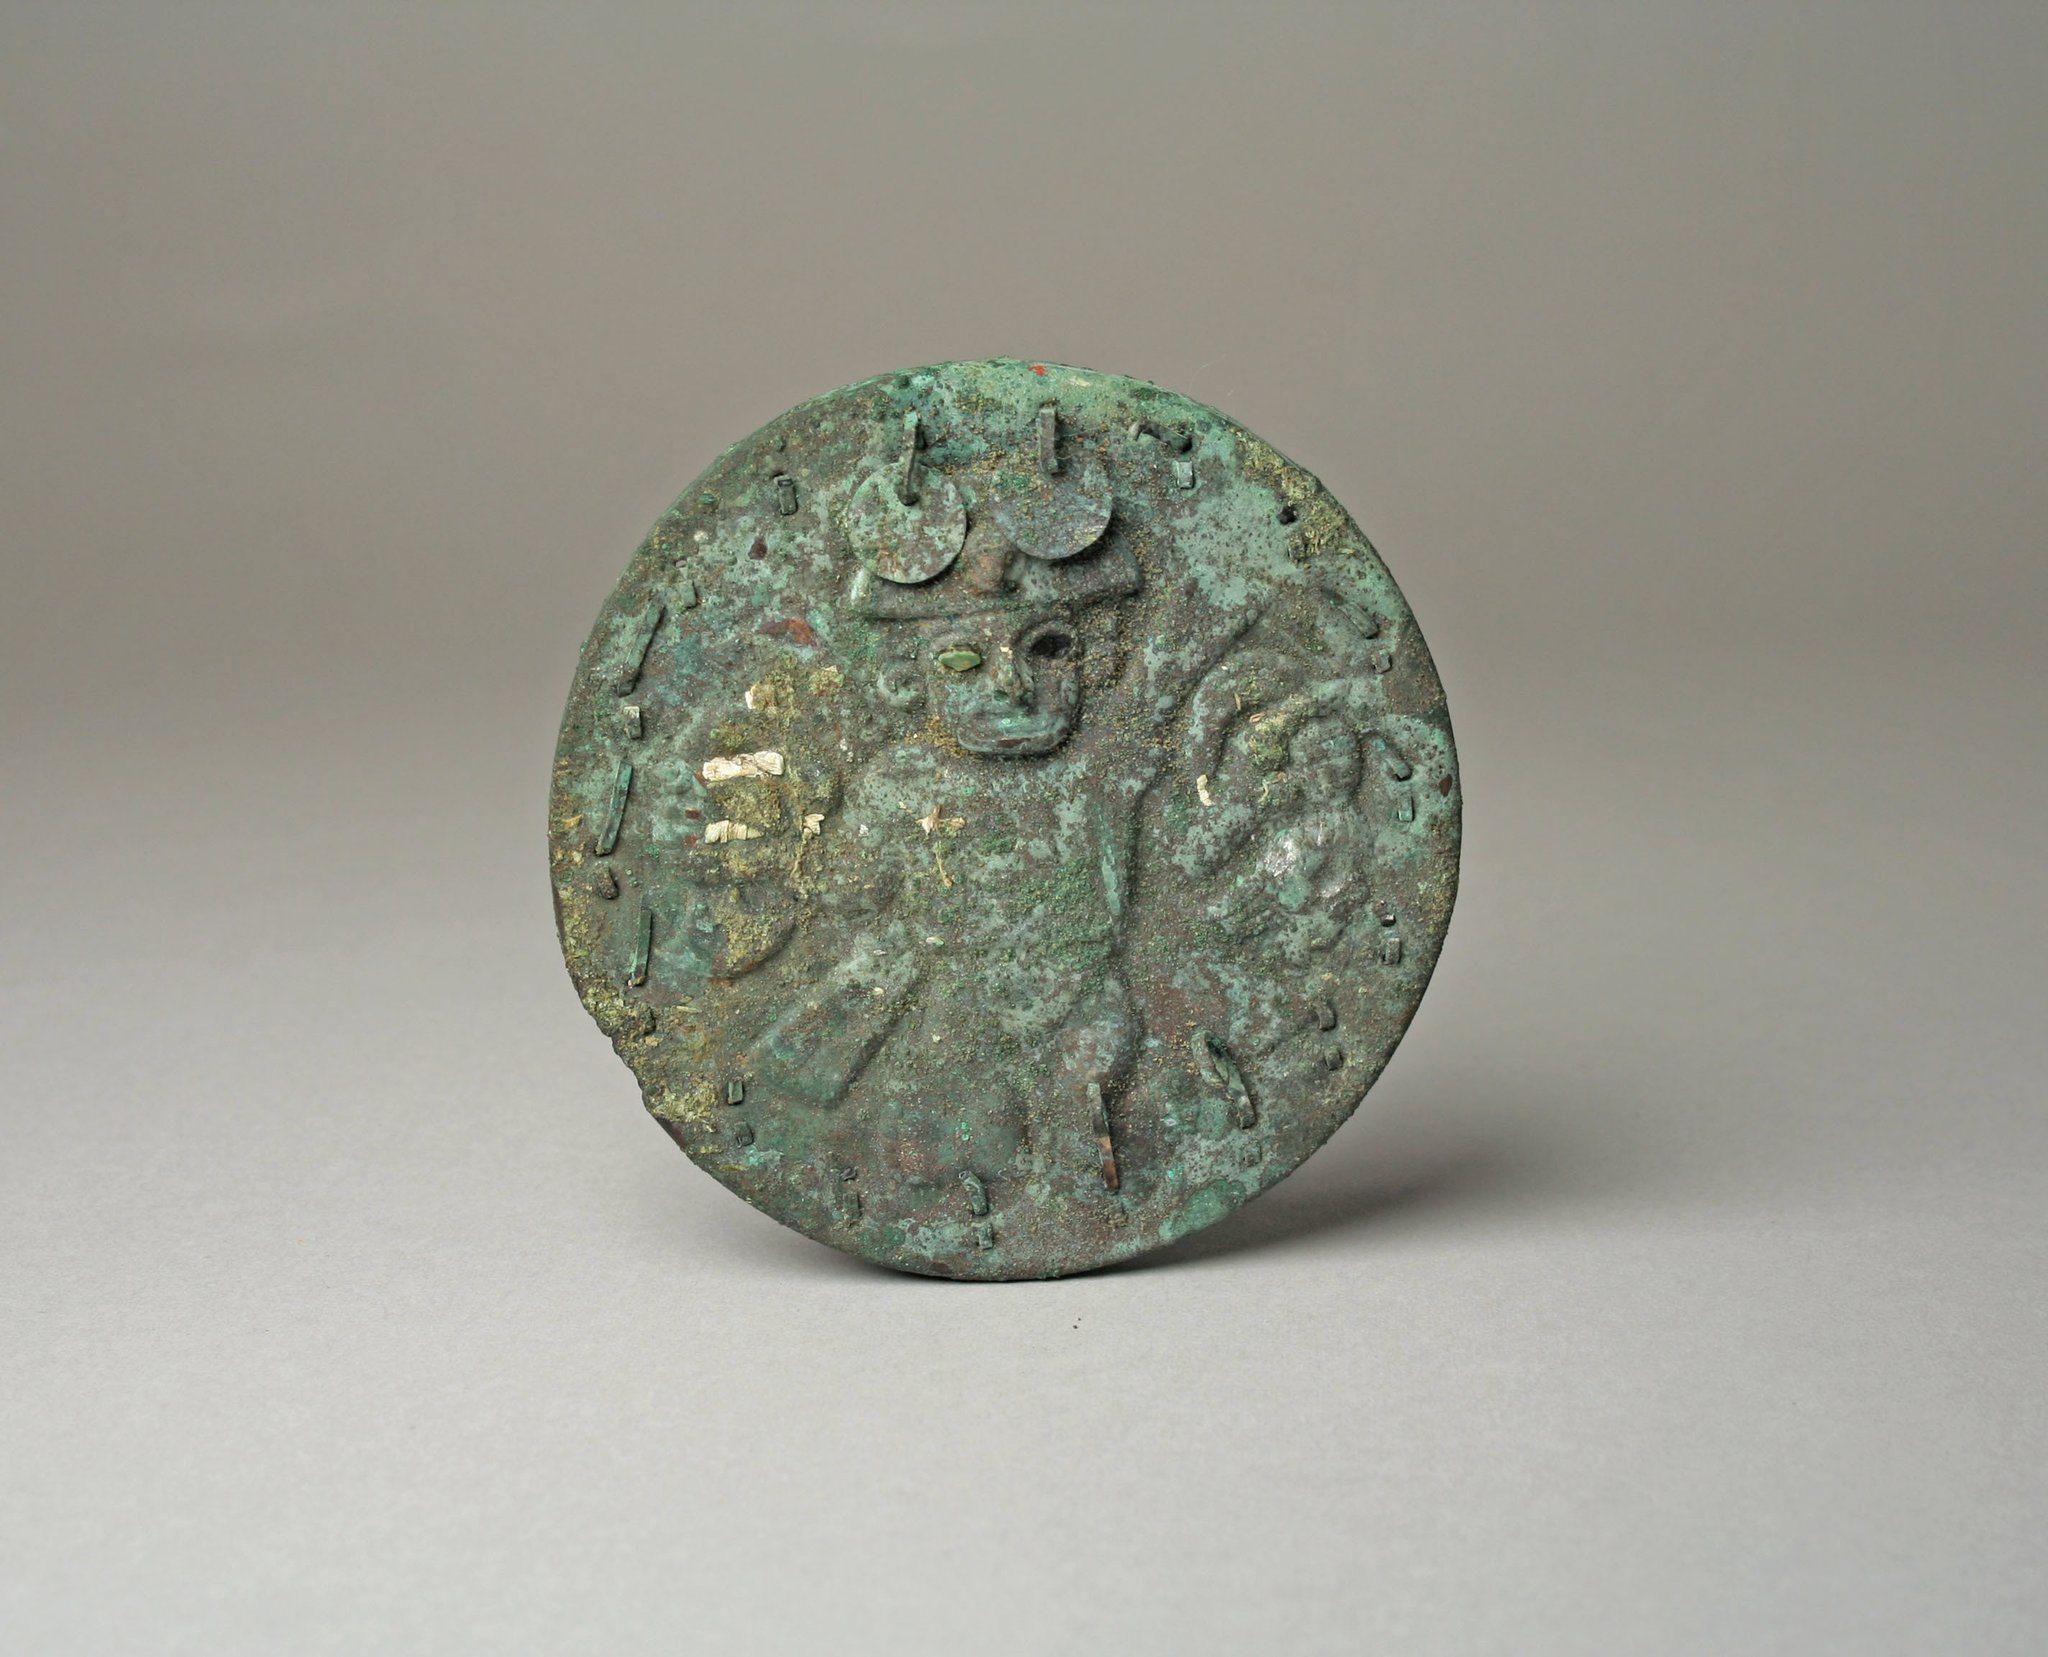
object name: earflare frontal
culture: moche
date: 501-700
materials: gilt copper, stone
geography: peru